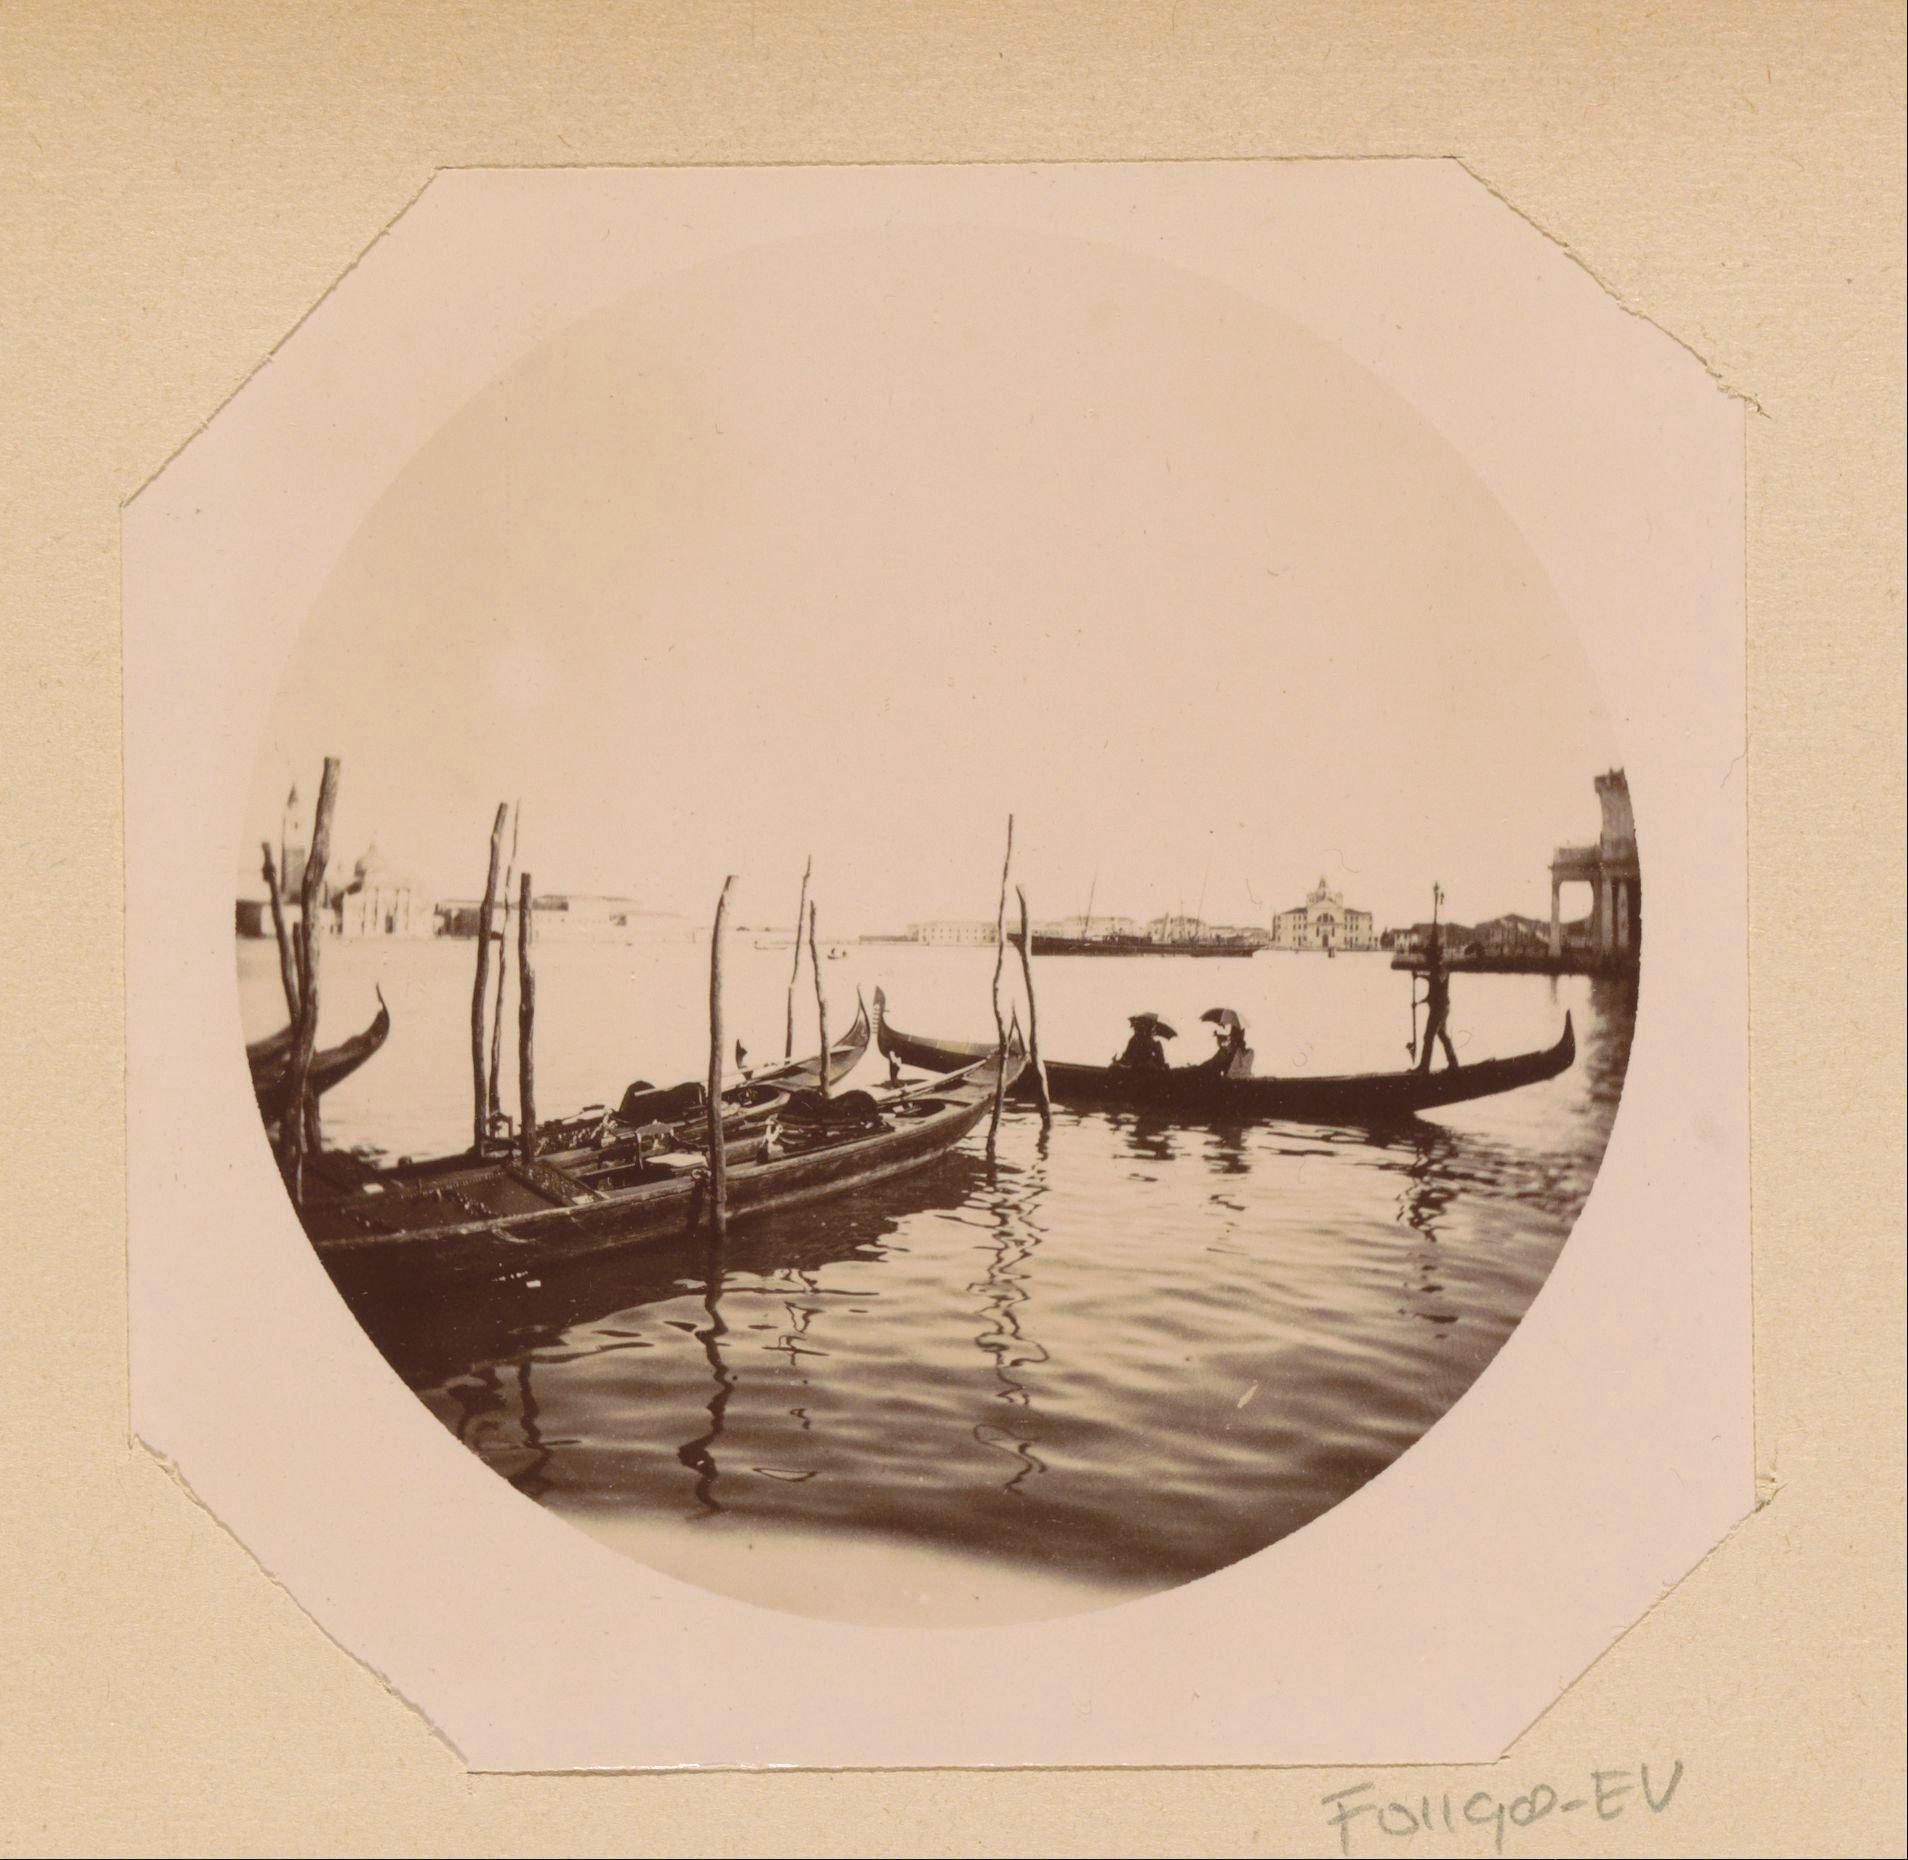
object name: photograph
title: Gezicht op gondels in de lagune van Venetië, in de verte rechts de Santa Maria della Presentazione en links de kerk van San Giorgio Maggiore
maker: johanna margaretha piek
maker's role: fotograaf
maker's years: 1870-1947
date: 1889-1893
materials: paper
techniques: gelatin silver print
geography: venice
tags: gondola